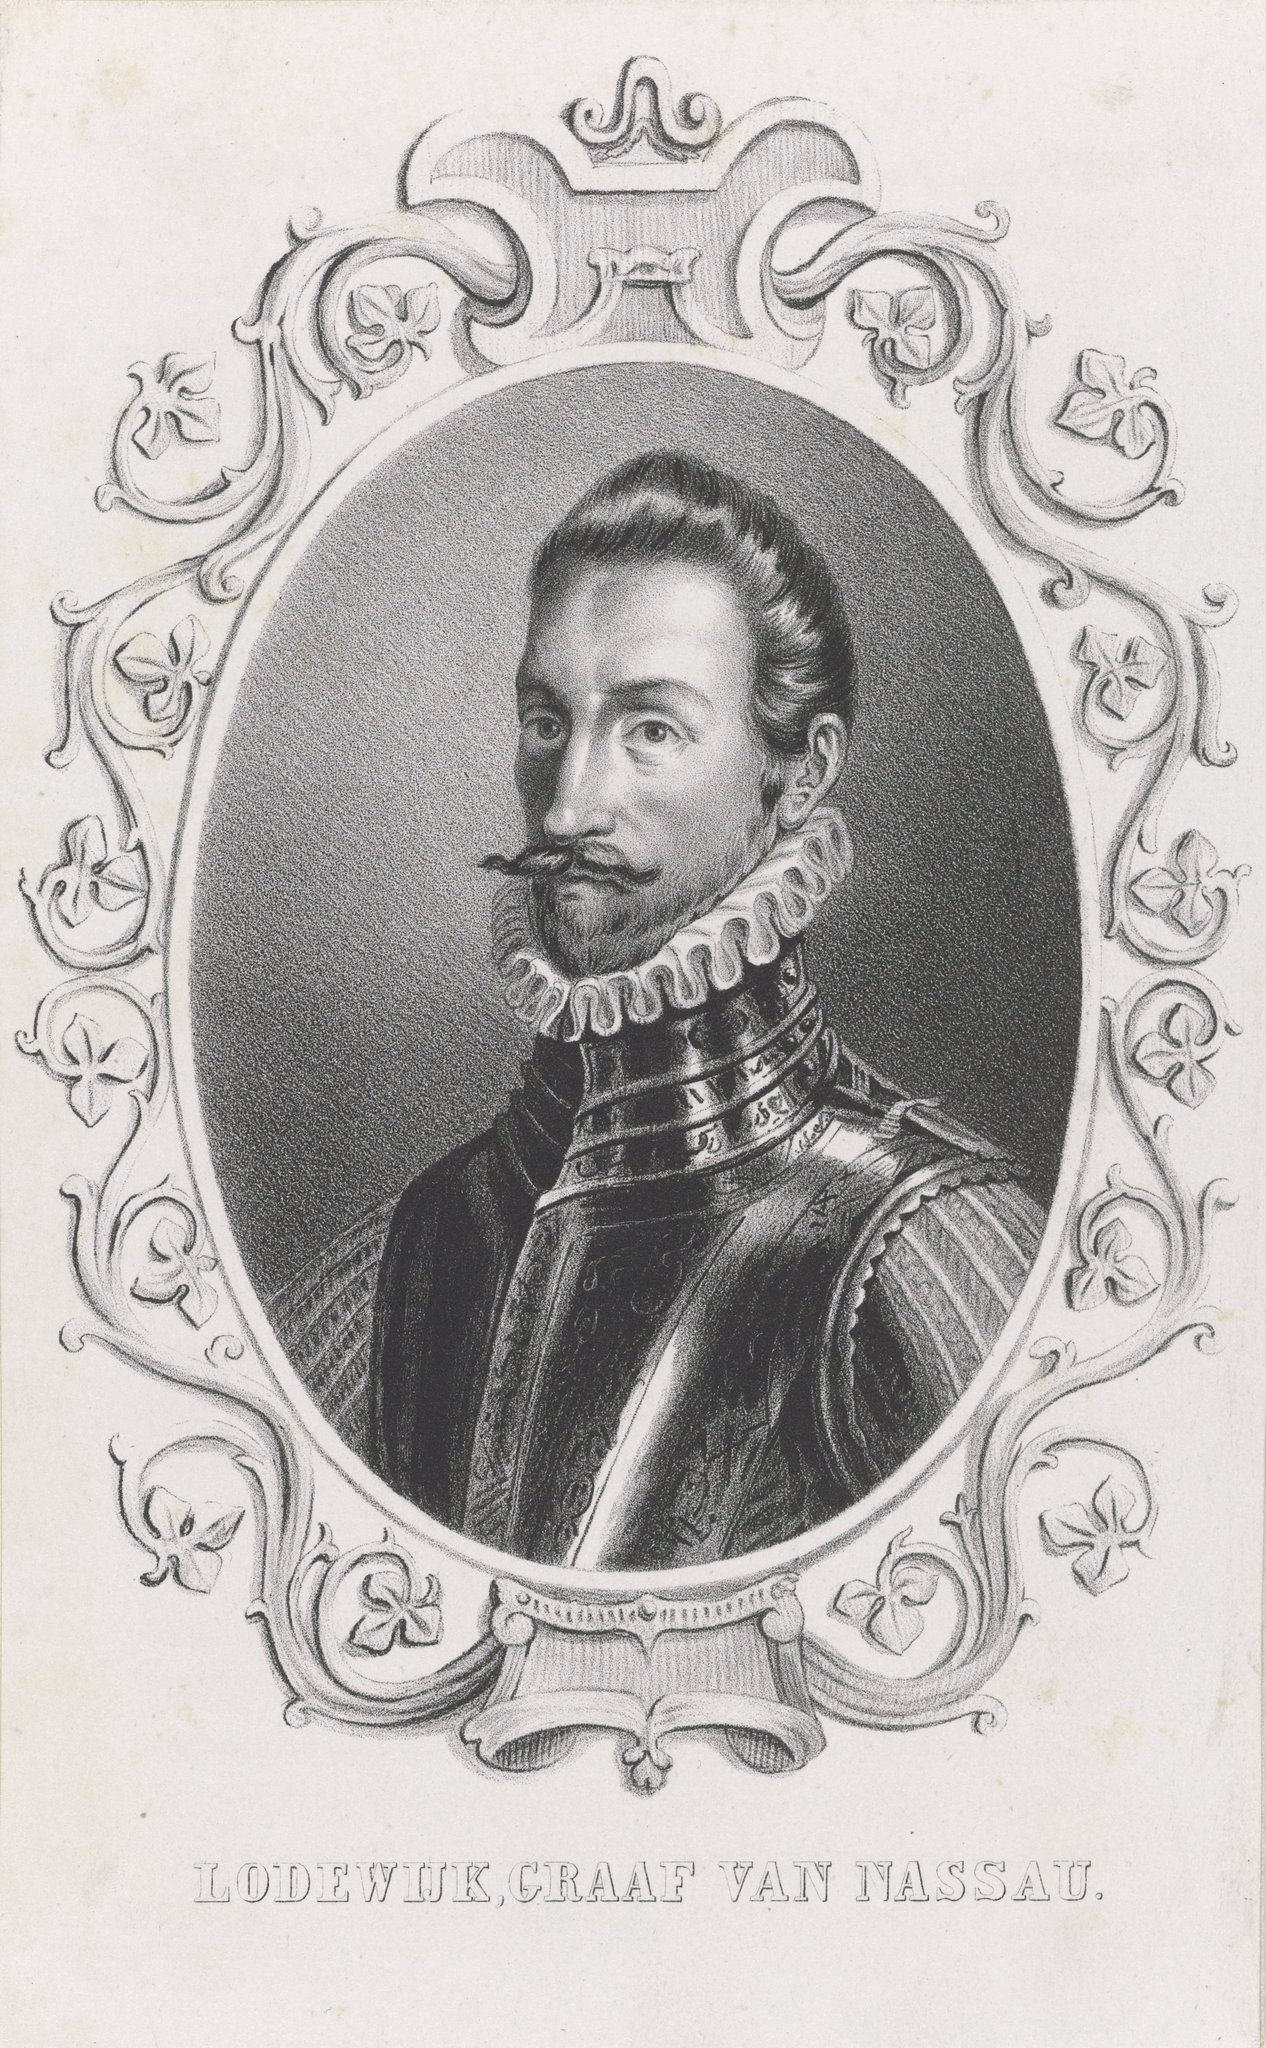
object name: print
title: Portret van Lodewijk, graaf van Nassau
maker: Anonymous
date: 1800-1899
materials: paper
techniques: lithograph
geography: low countries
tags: dillenburg, lodewijk graaf van nassau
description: De hier vermelde titel verwijst naar de hoogst verkregen titel van de geportretteerde, niet per se naar de titel die de geportretteerde op deze voorstelling draagt.